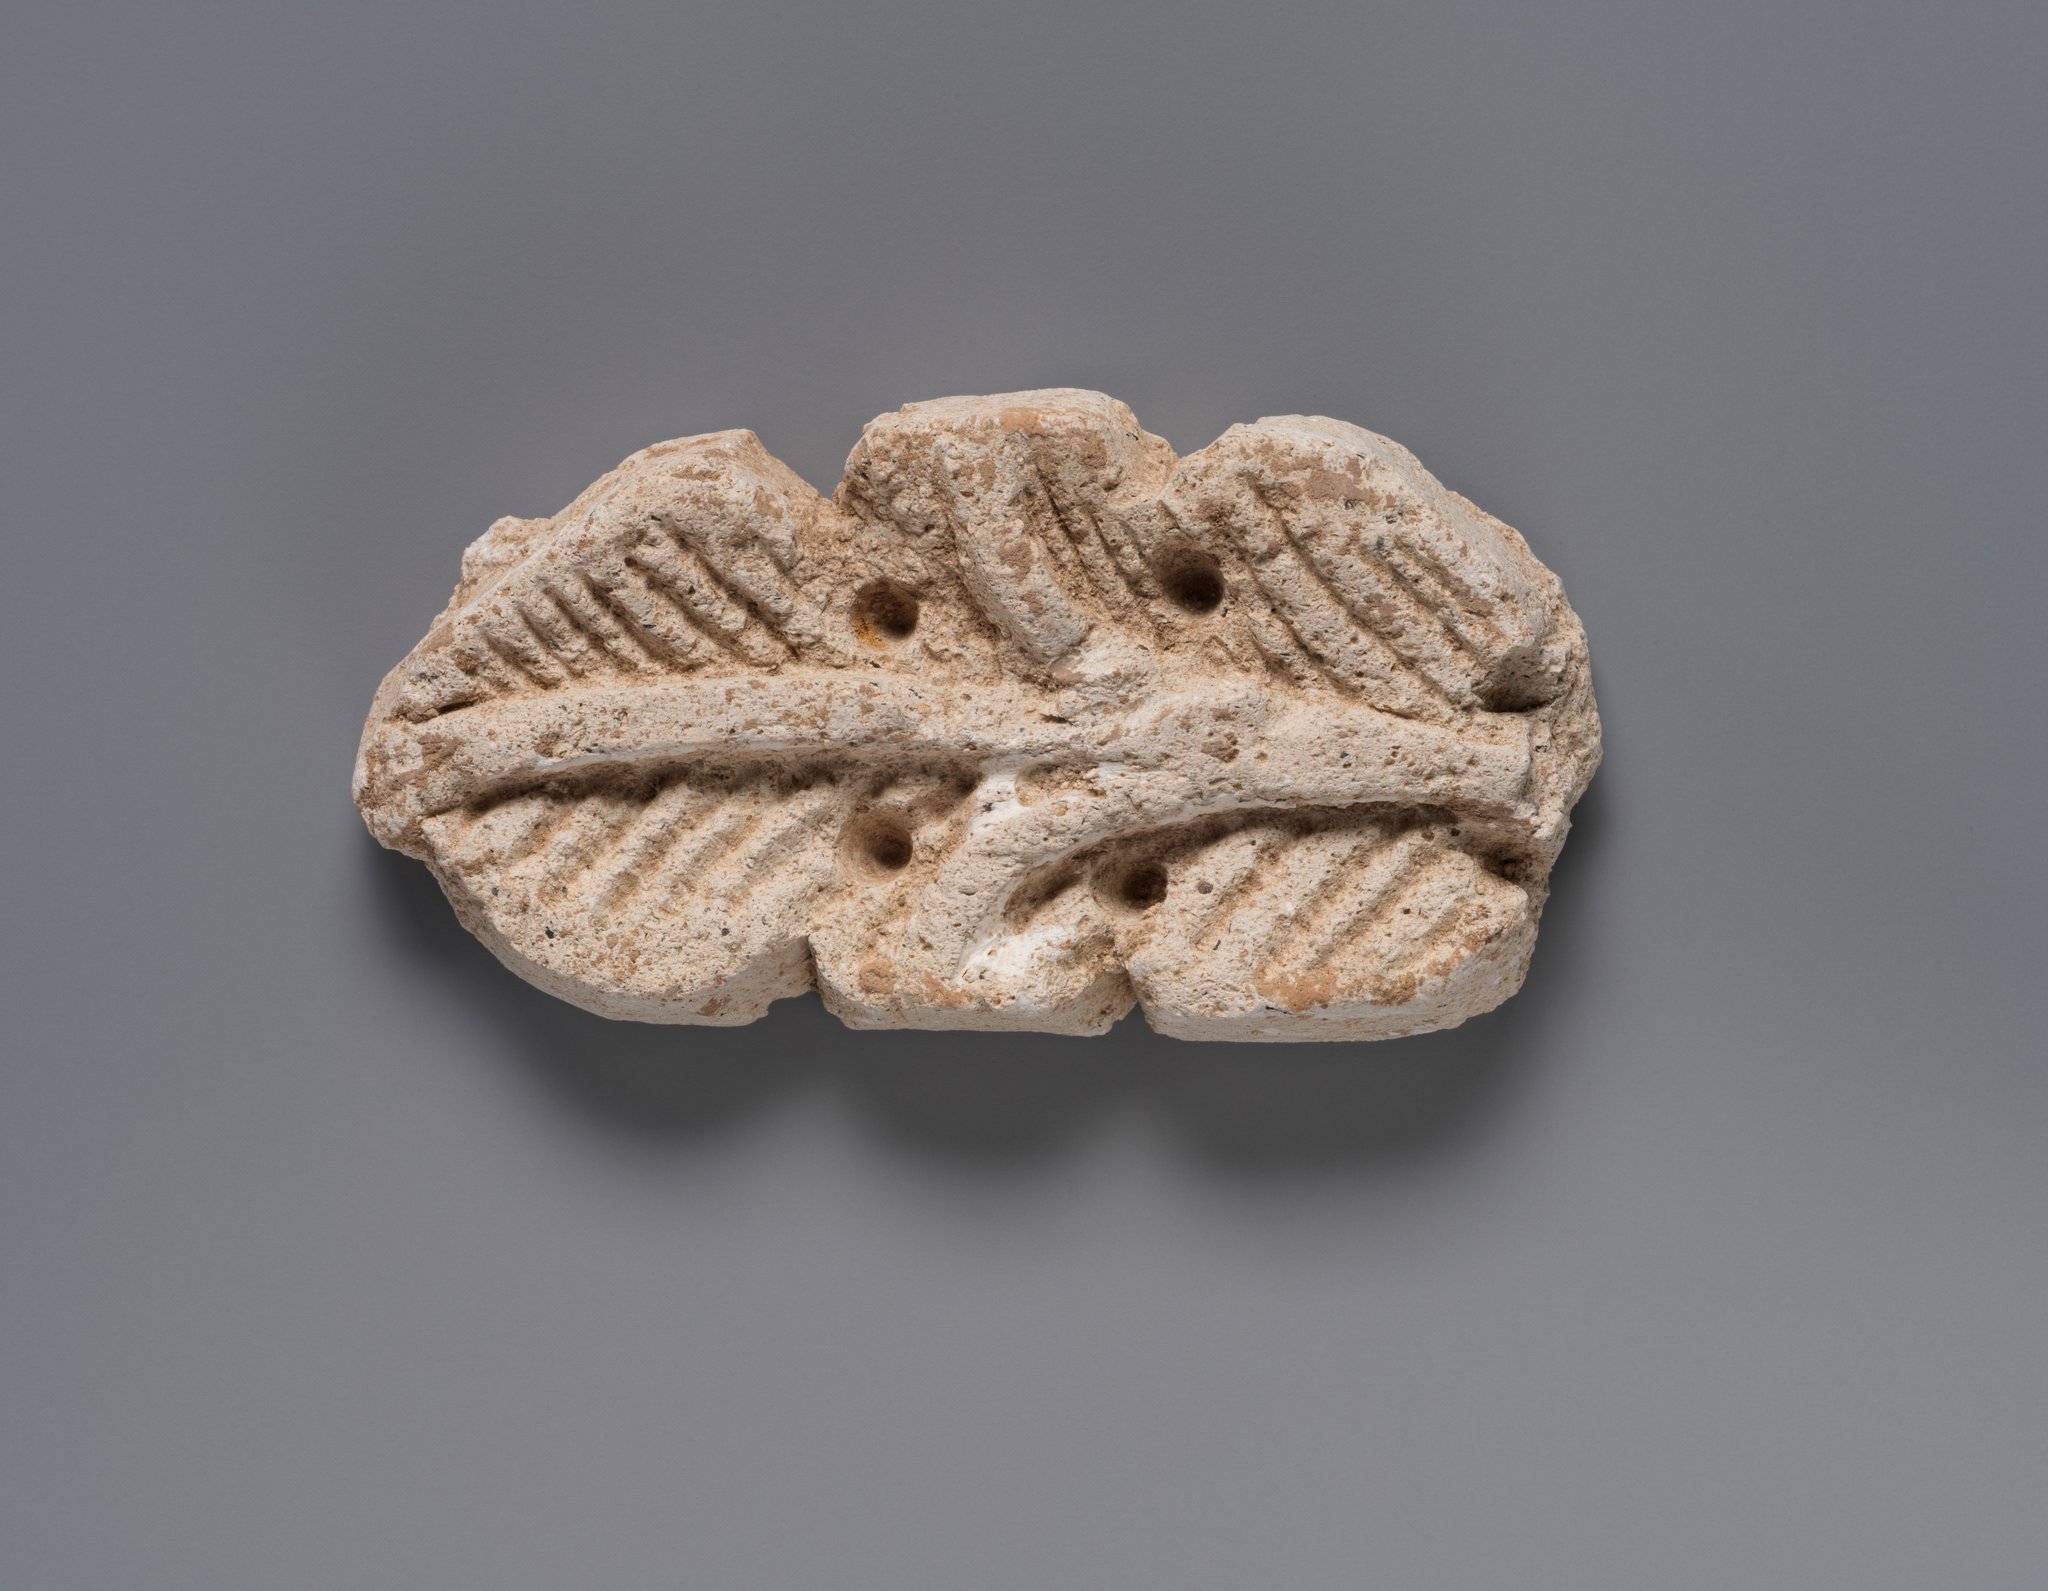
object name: fragment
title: Stucco Fragment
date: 701-1200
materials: plaster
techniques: carving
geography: iran